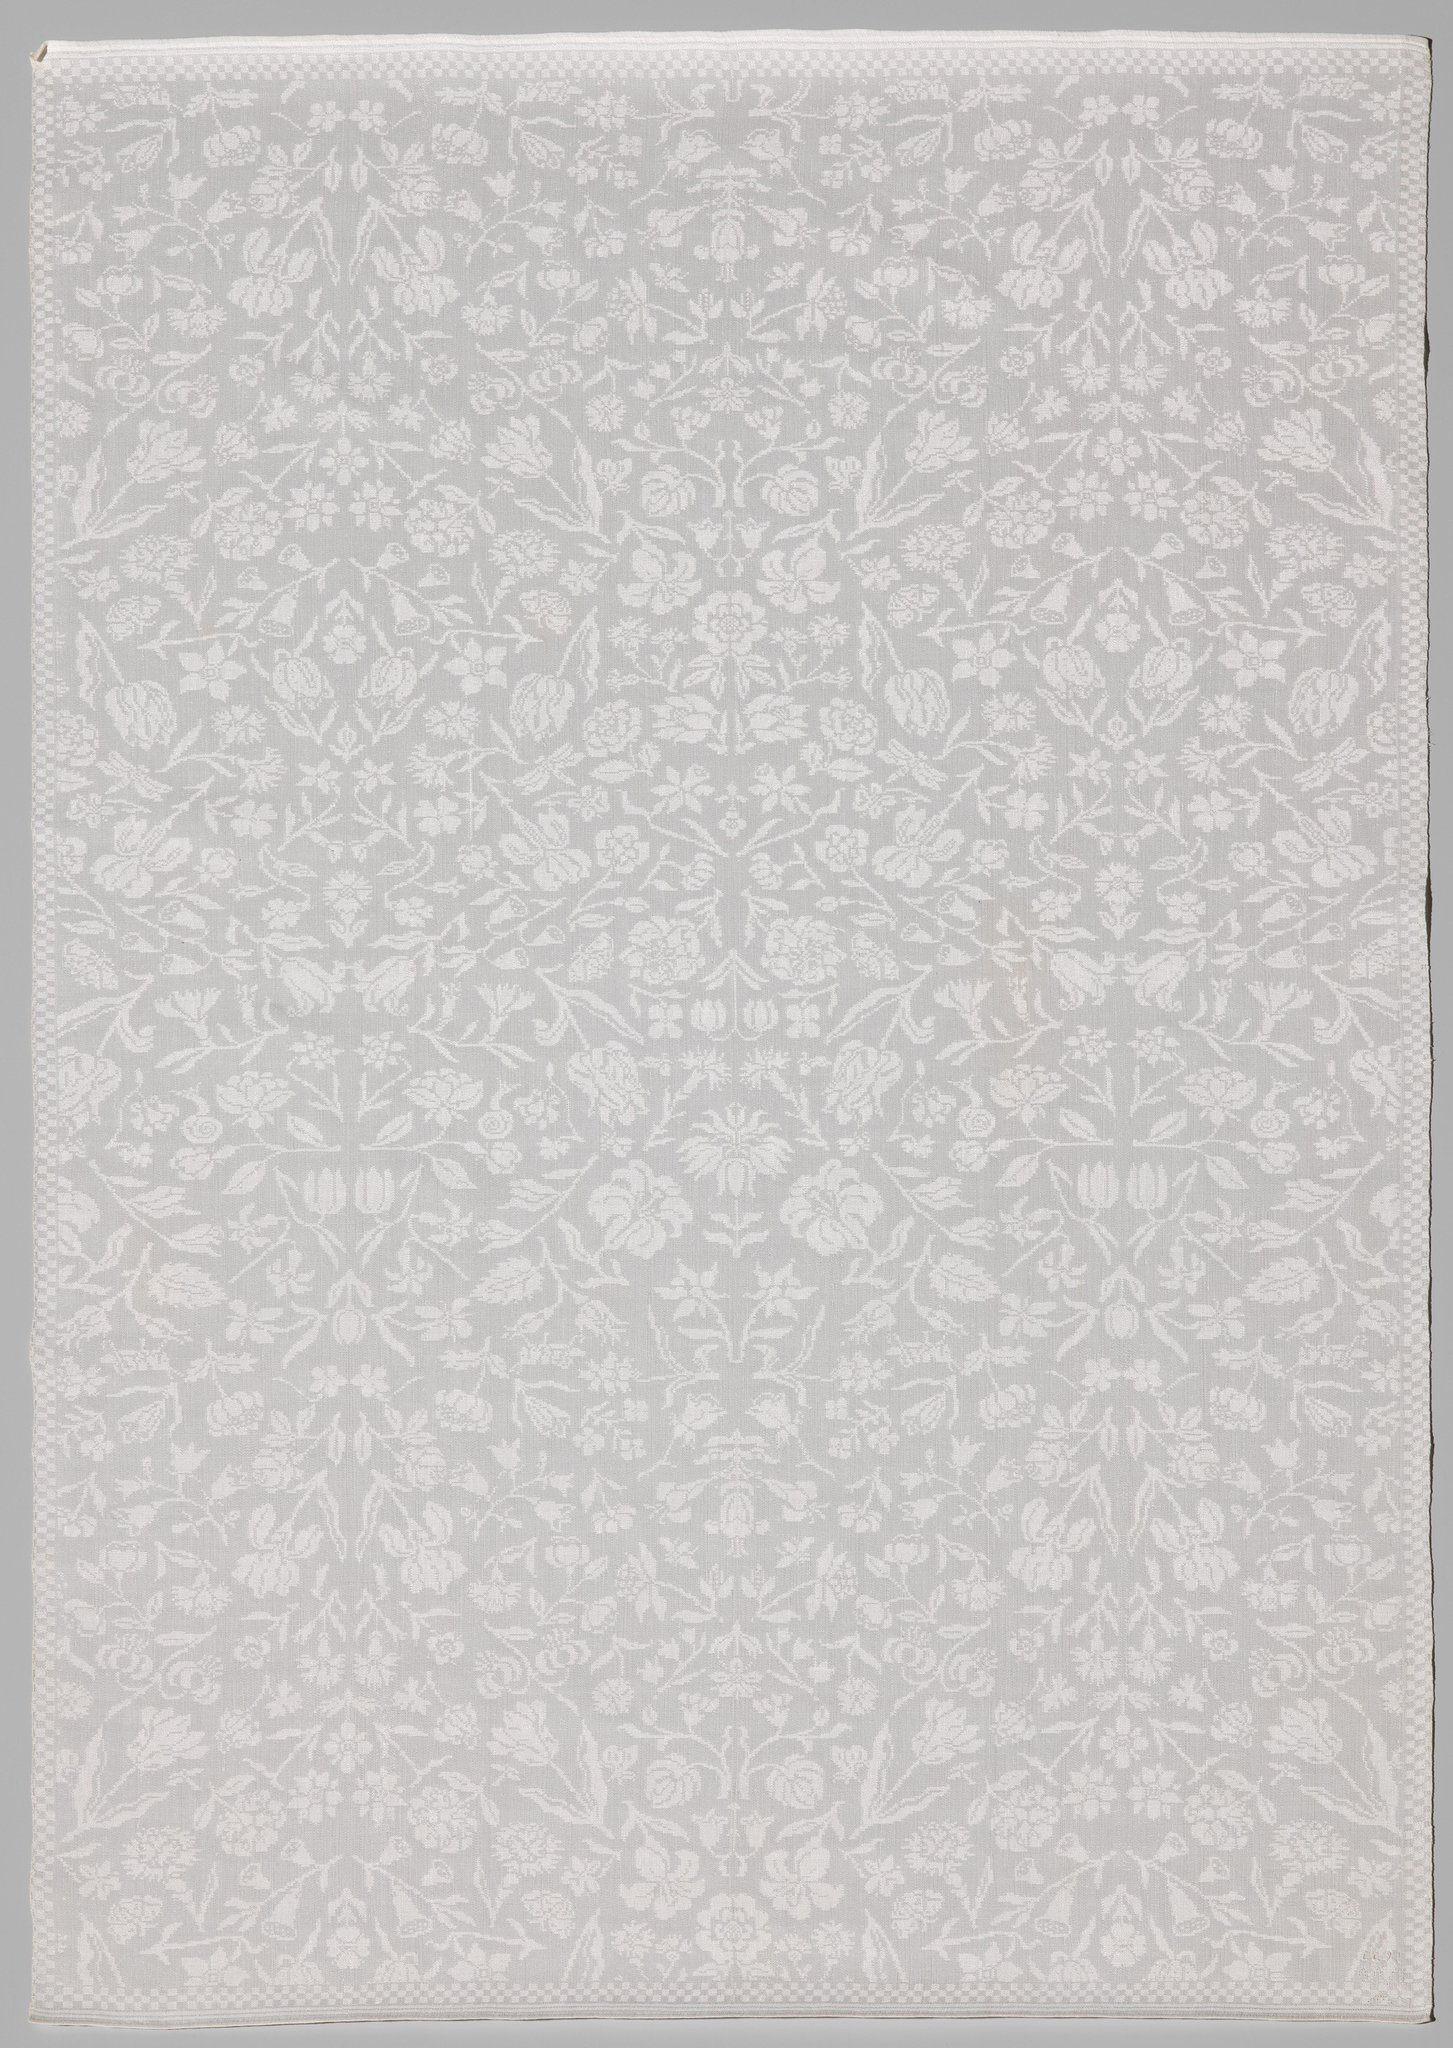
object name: napkin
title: Servet van wit linnendamast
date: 1677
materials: linen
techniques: damask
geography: netherlands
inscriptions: mark: ‘1677’, mark: ‘kroon LVV’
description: Wit linnen damasten servet met gestrooide bloemen, waaronder keizerskroon, slak, vlinders en andere insecten.